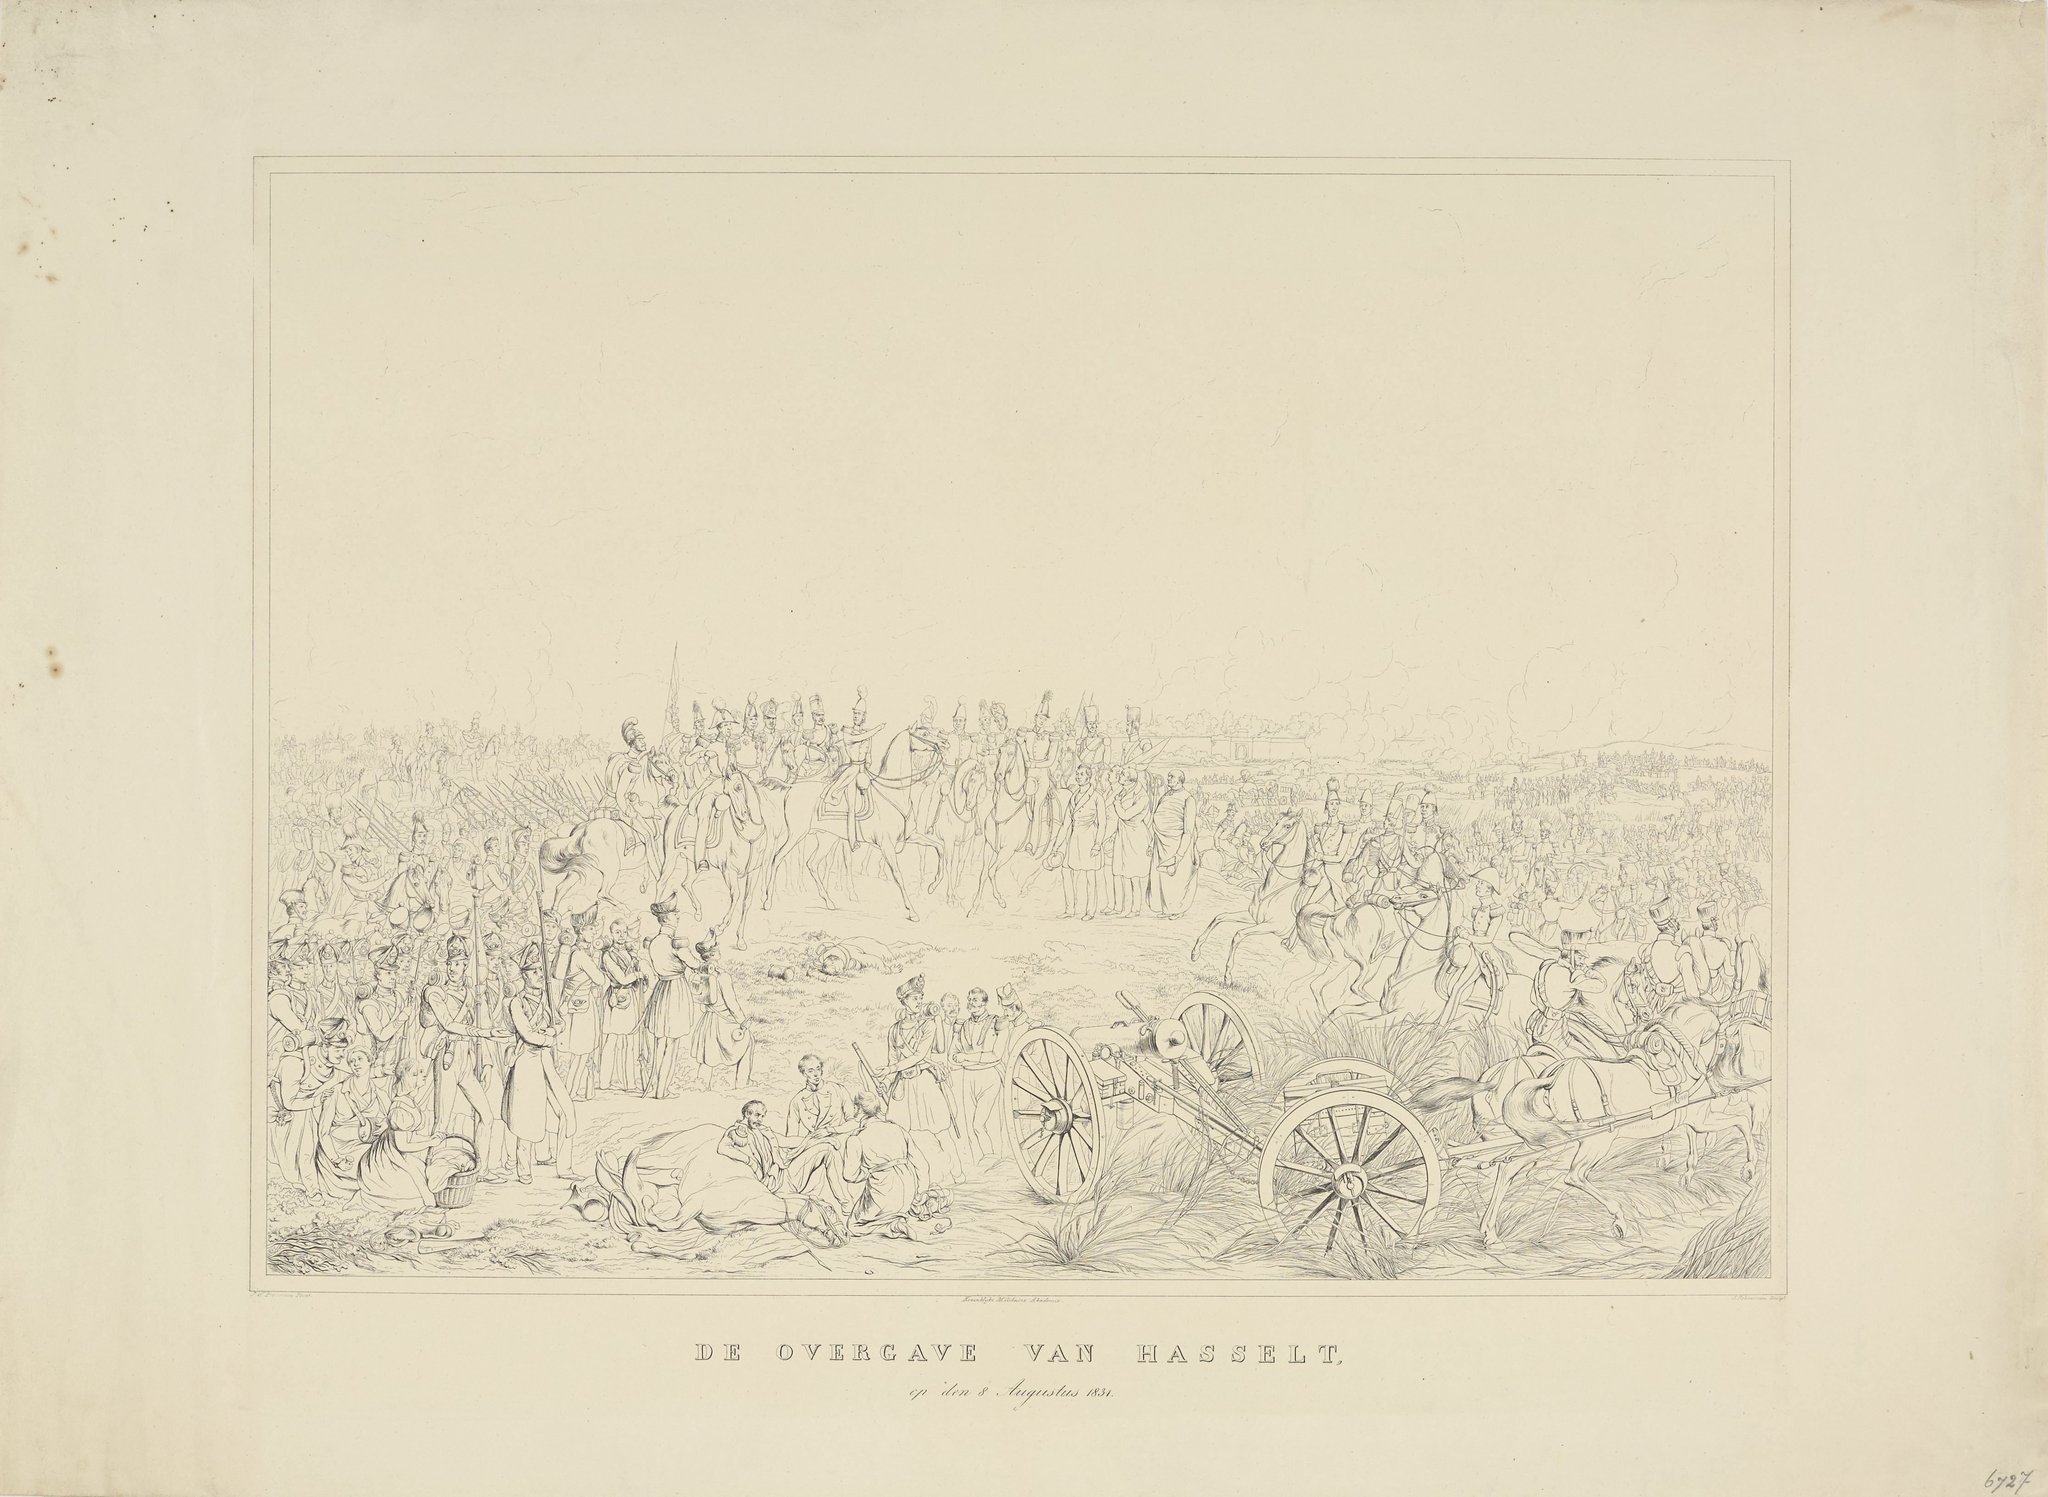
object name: print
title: De Overgave van Hasselt, op den 8 Augustus 1831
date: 1835-1837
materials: paper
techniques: lithograph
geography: netherlands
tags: william ii of the netherlands, berlin, frederik (prins der nederlanden), battle (+ land forces)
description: De overgave van de stad Hasselt aan de Nederlandse troepen onder bevel van de prins van Oranje, 8 augustus 1831. Gezicht op het slagveld met centraal op een heuveltje de prins omringd door zijn staf, allen te paard, rechts van hen een afvaardiging van de stad Hasselt onder leiding van de burgemeester om over de overgave van de stad te onderhandelen. Rechts prins Frederik tussen enkele officieren. Op de voorgrond wordt een gewonde militair verzorgd. Aan de linkerkant leden van de Leidsche Vrijwillige Jagers en de Jagers van Rookmaker. Voorstelling in contouren. Bij de prent behoort een sleutel uit 1897 met de namen van de voorgestelden.